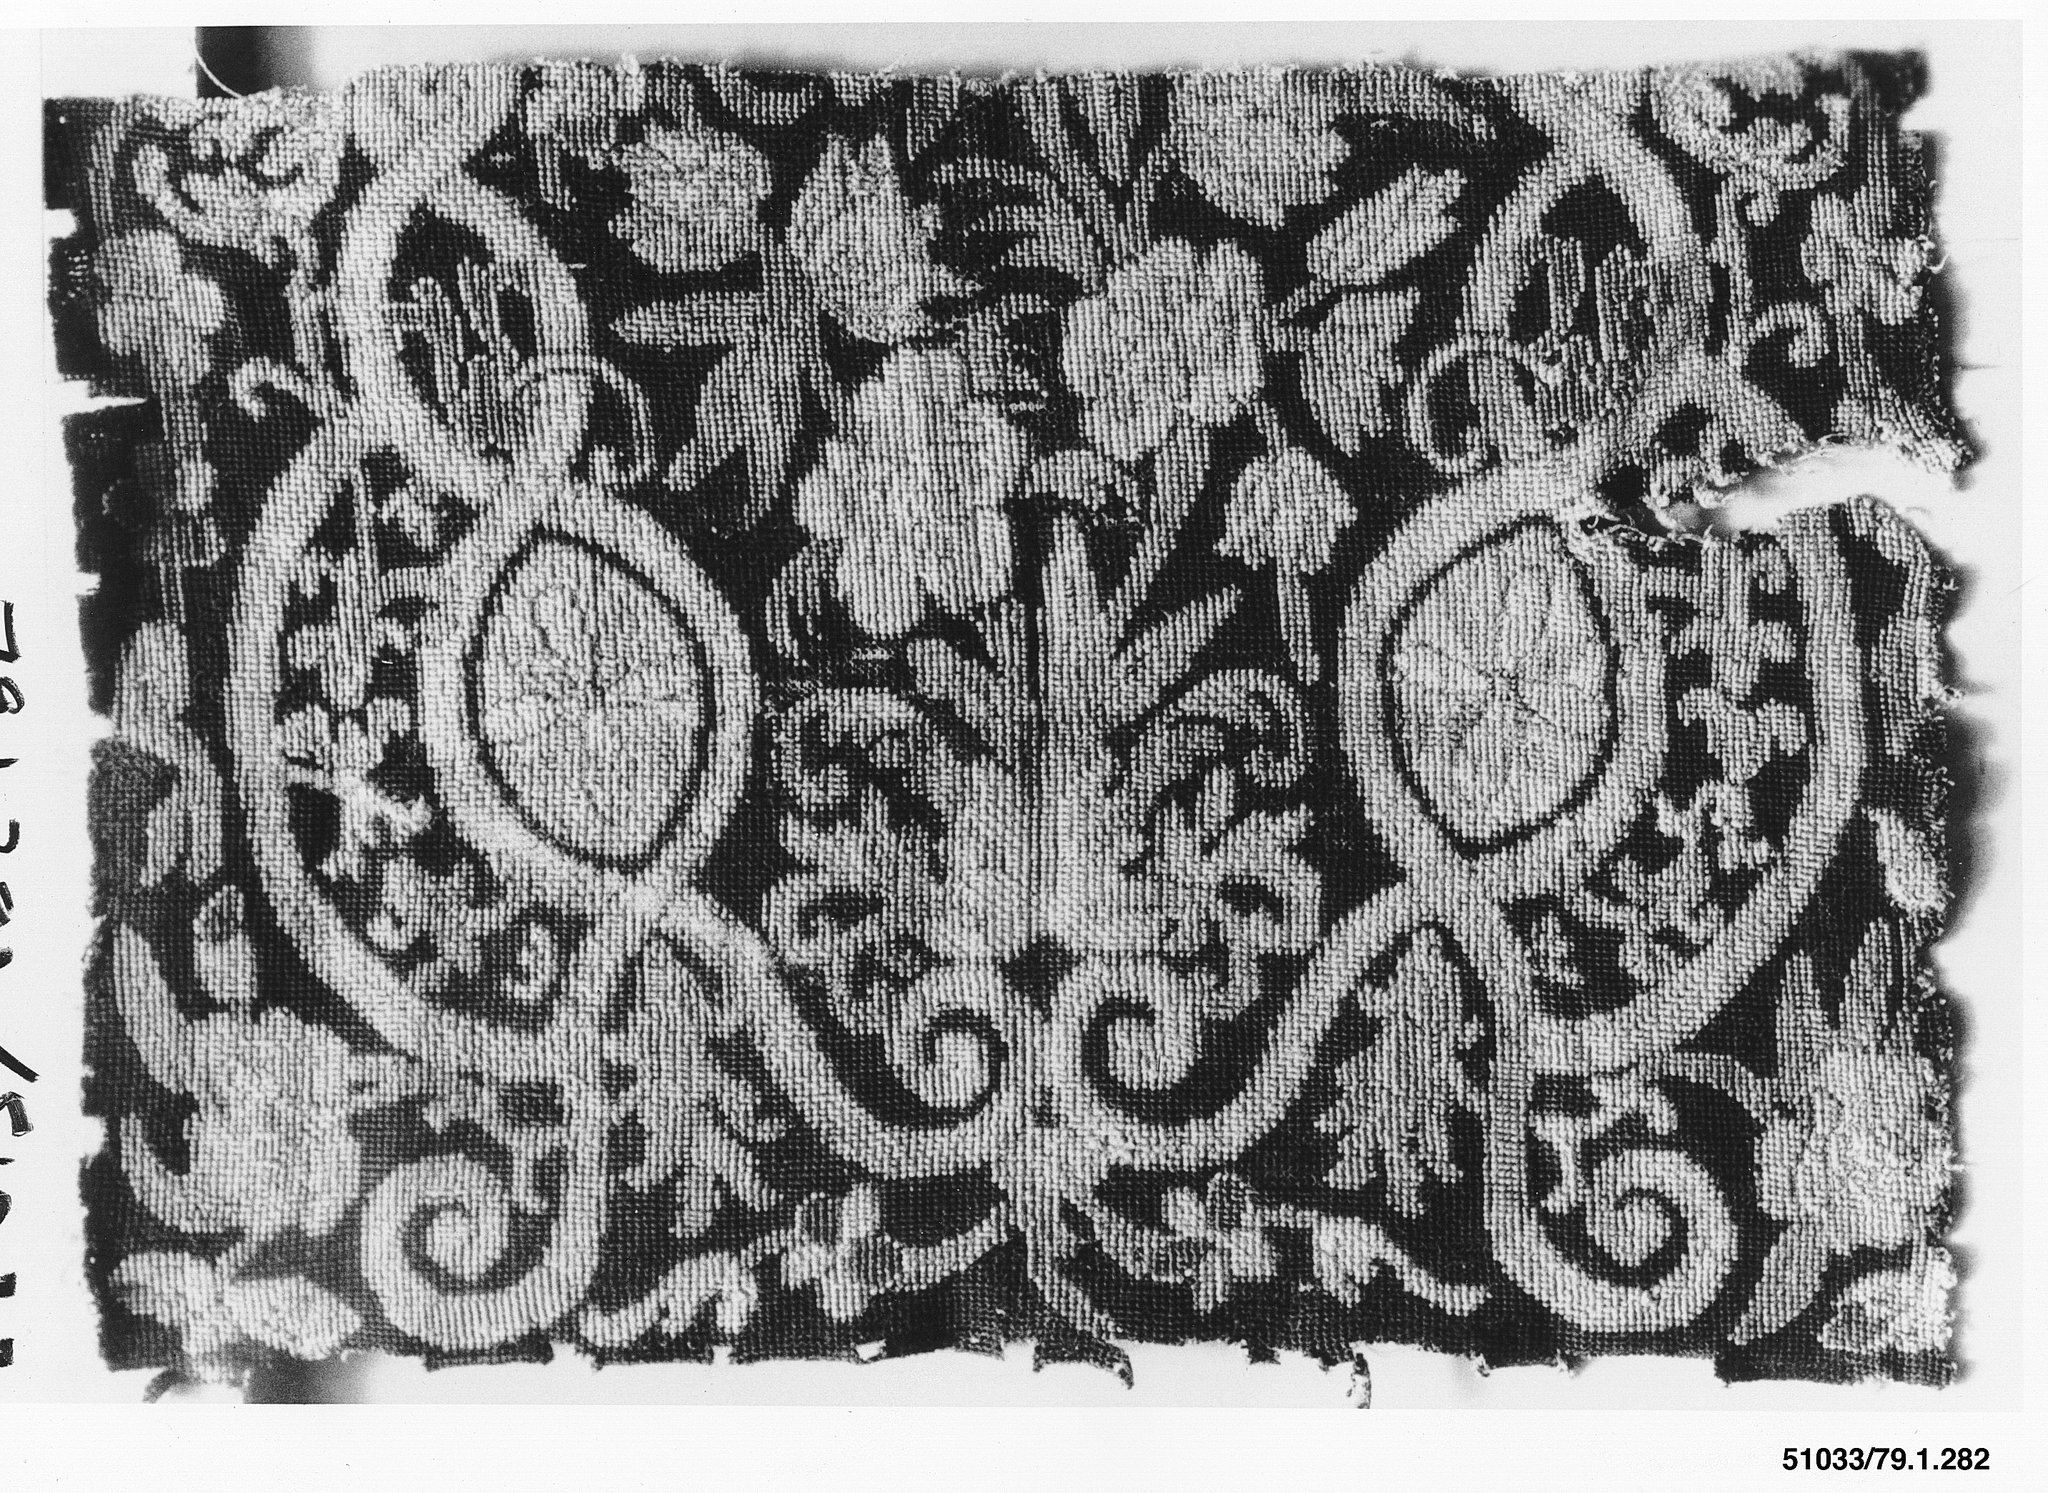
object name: fragment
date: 1601-1800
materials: silk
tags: flowers,leaves